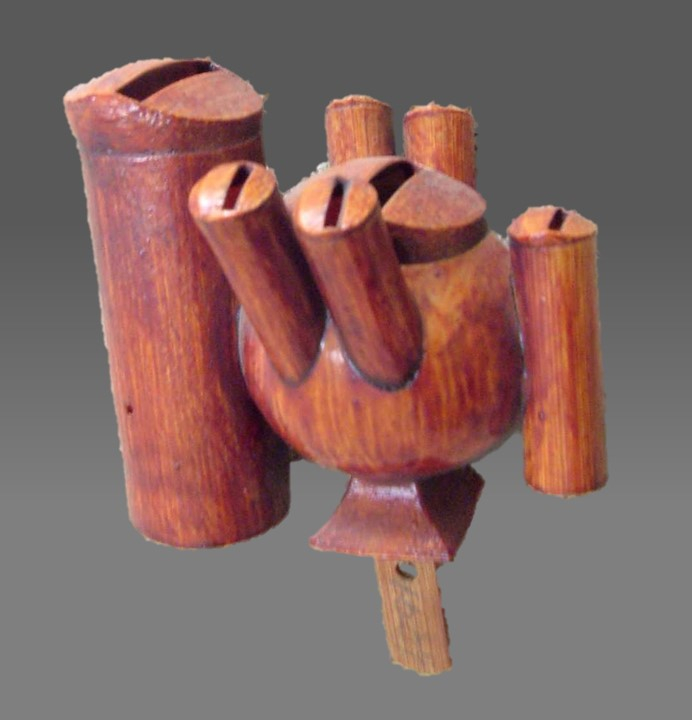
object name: ko tze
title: Ko-Tze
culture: chinese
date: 1867-1900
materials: bamboo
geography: china